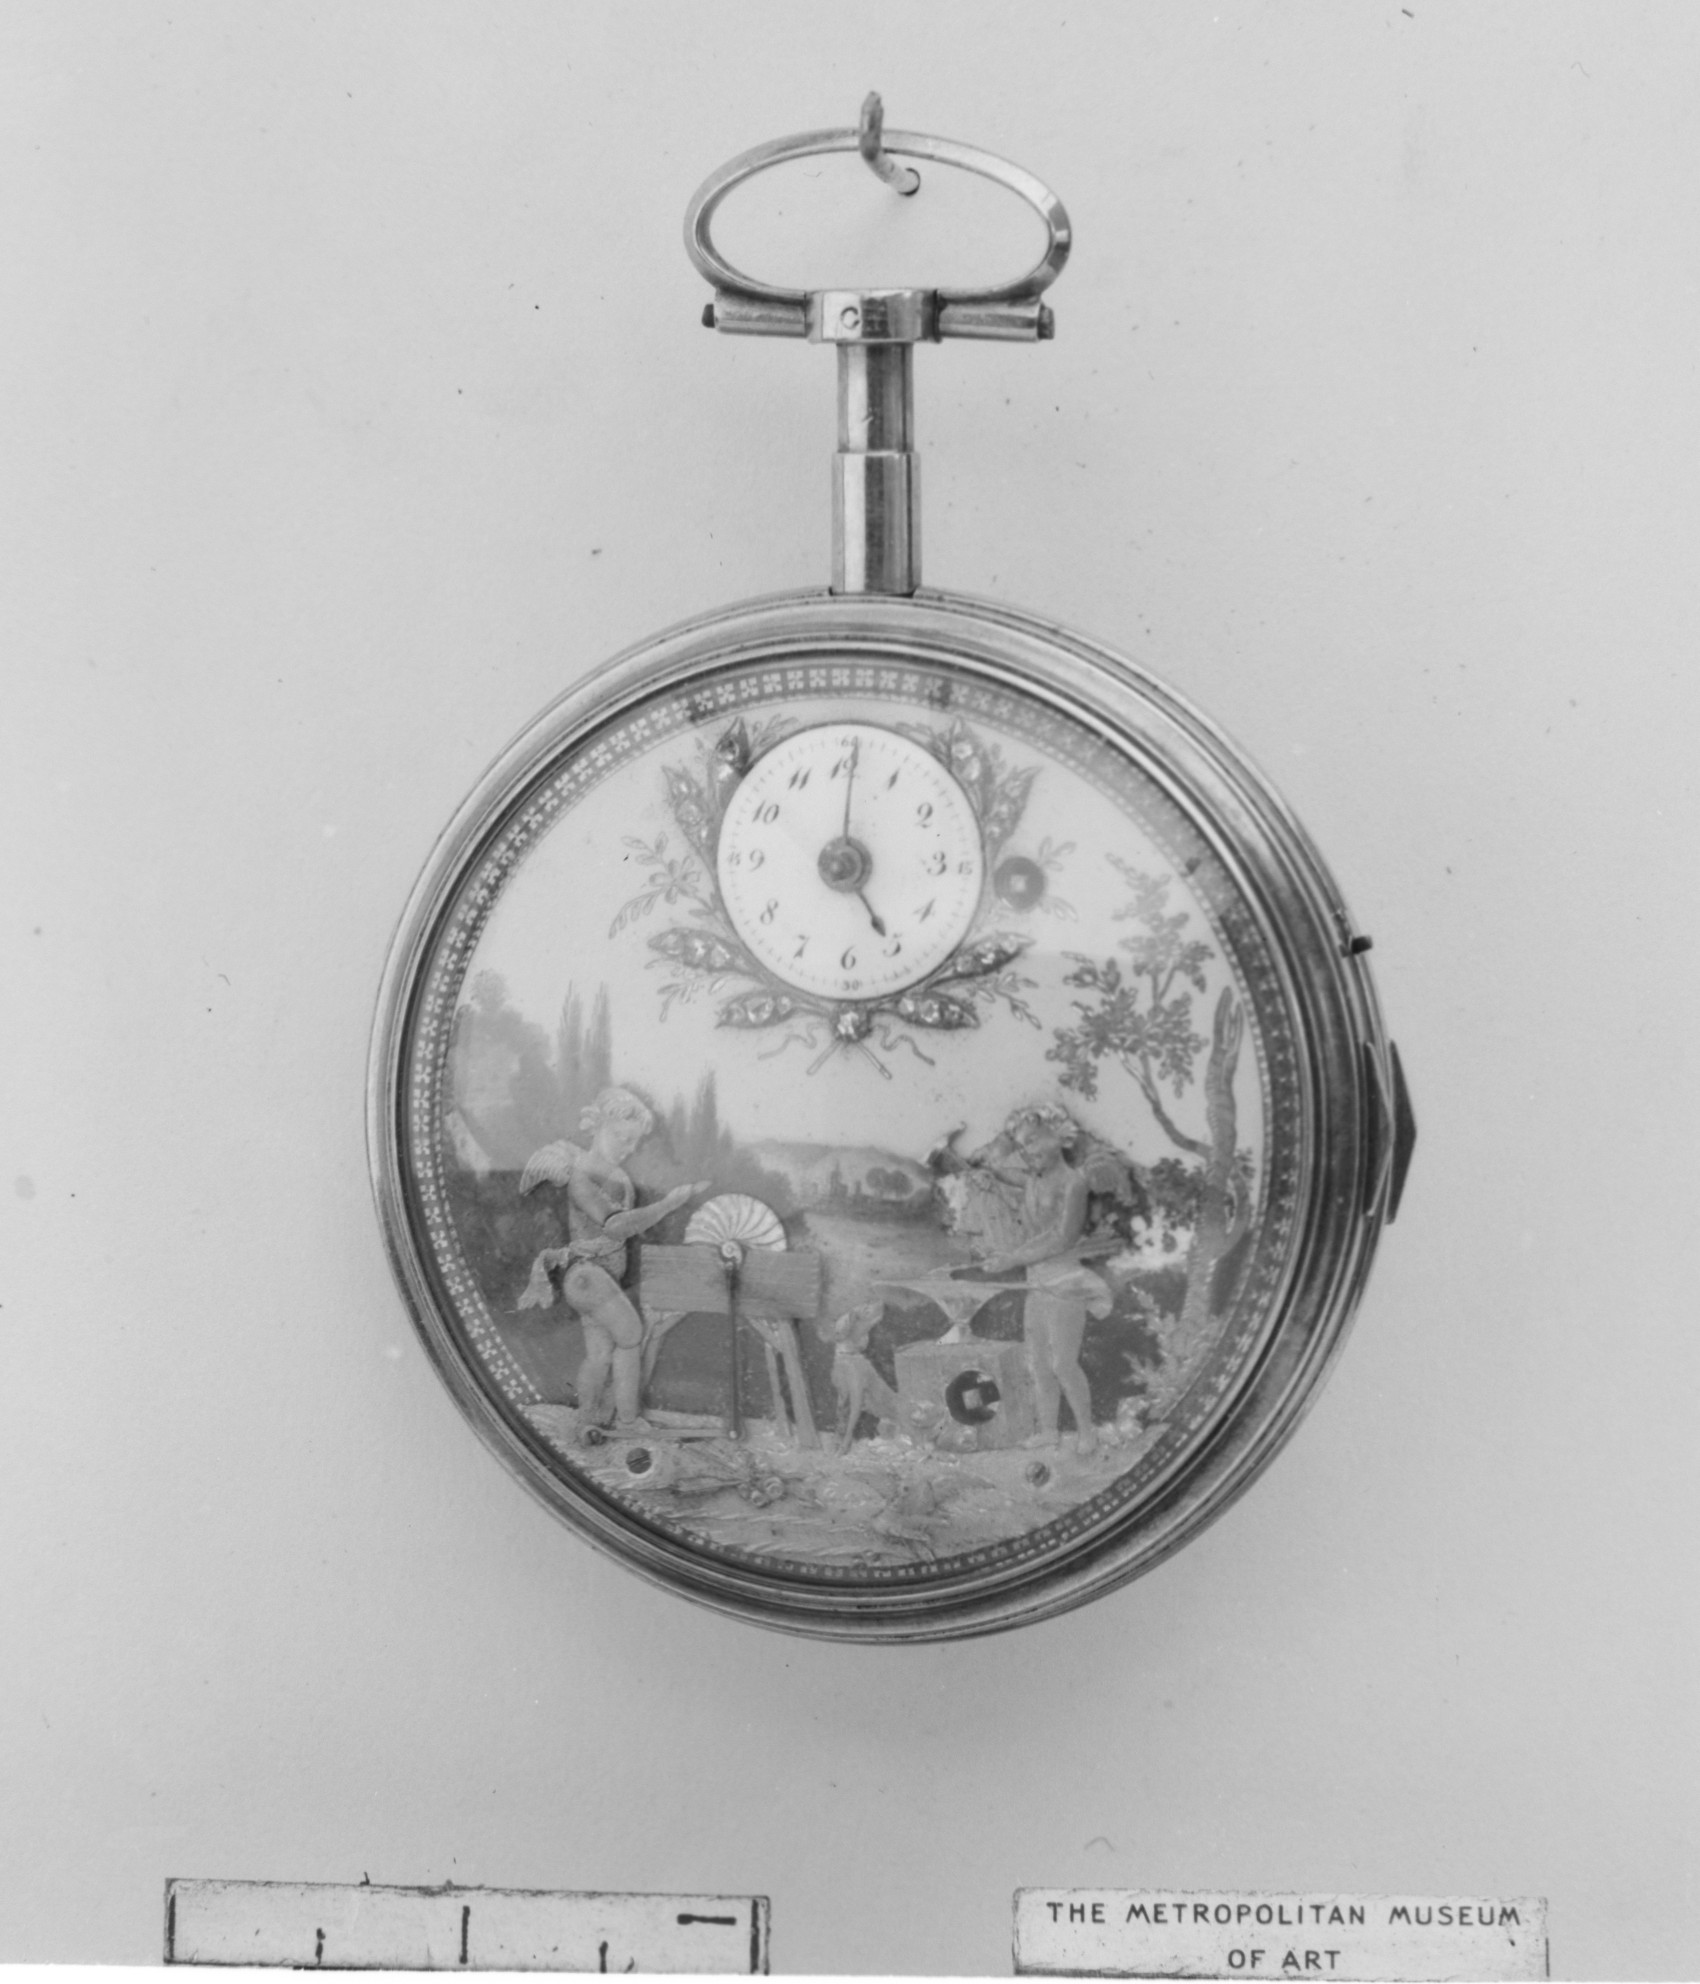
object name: watch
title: Mechanical watch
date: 1810-1820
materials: diamond, enamel, gold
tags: putti